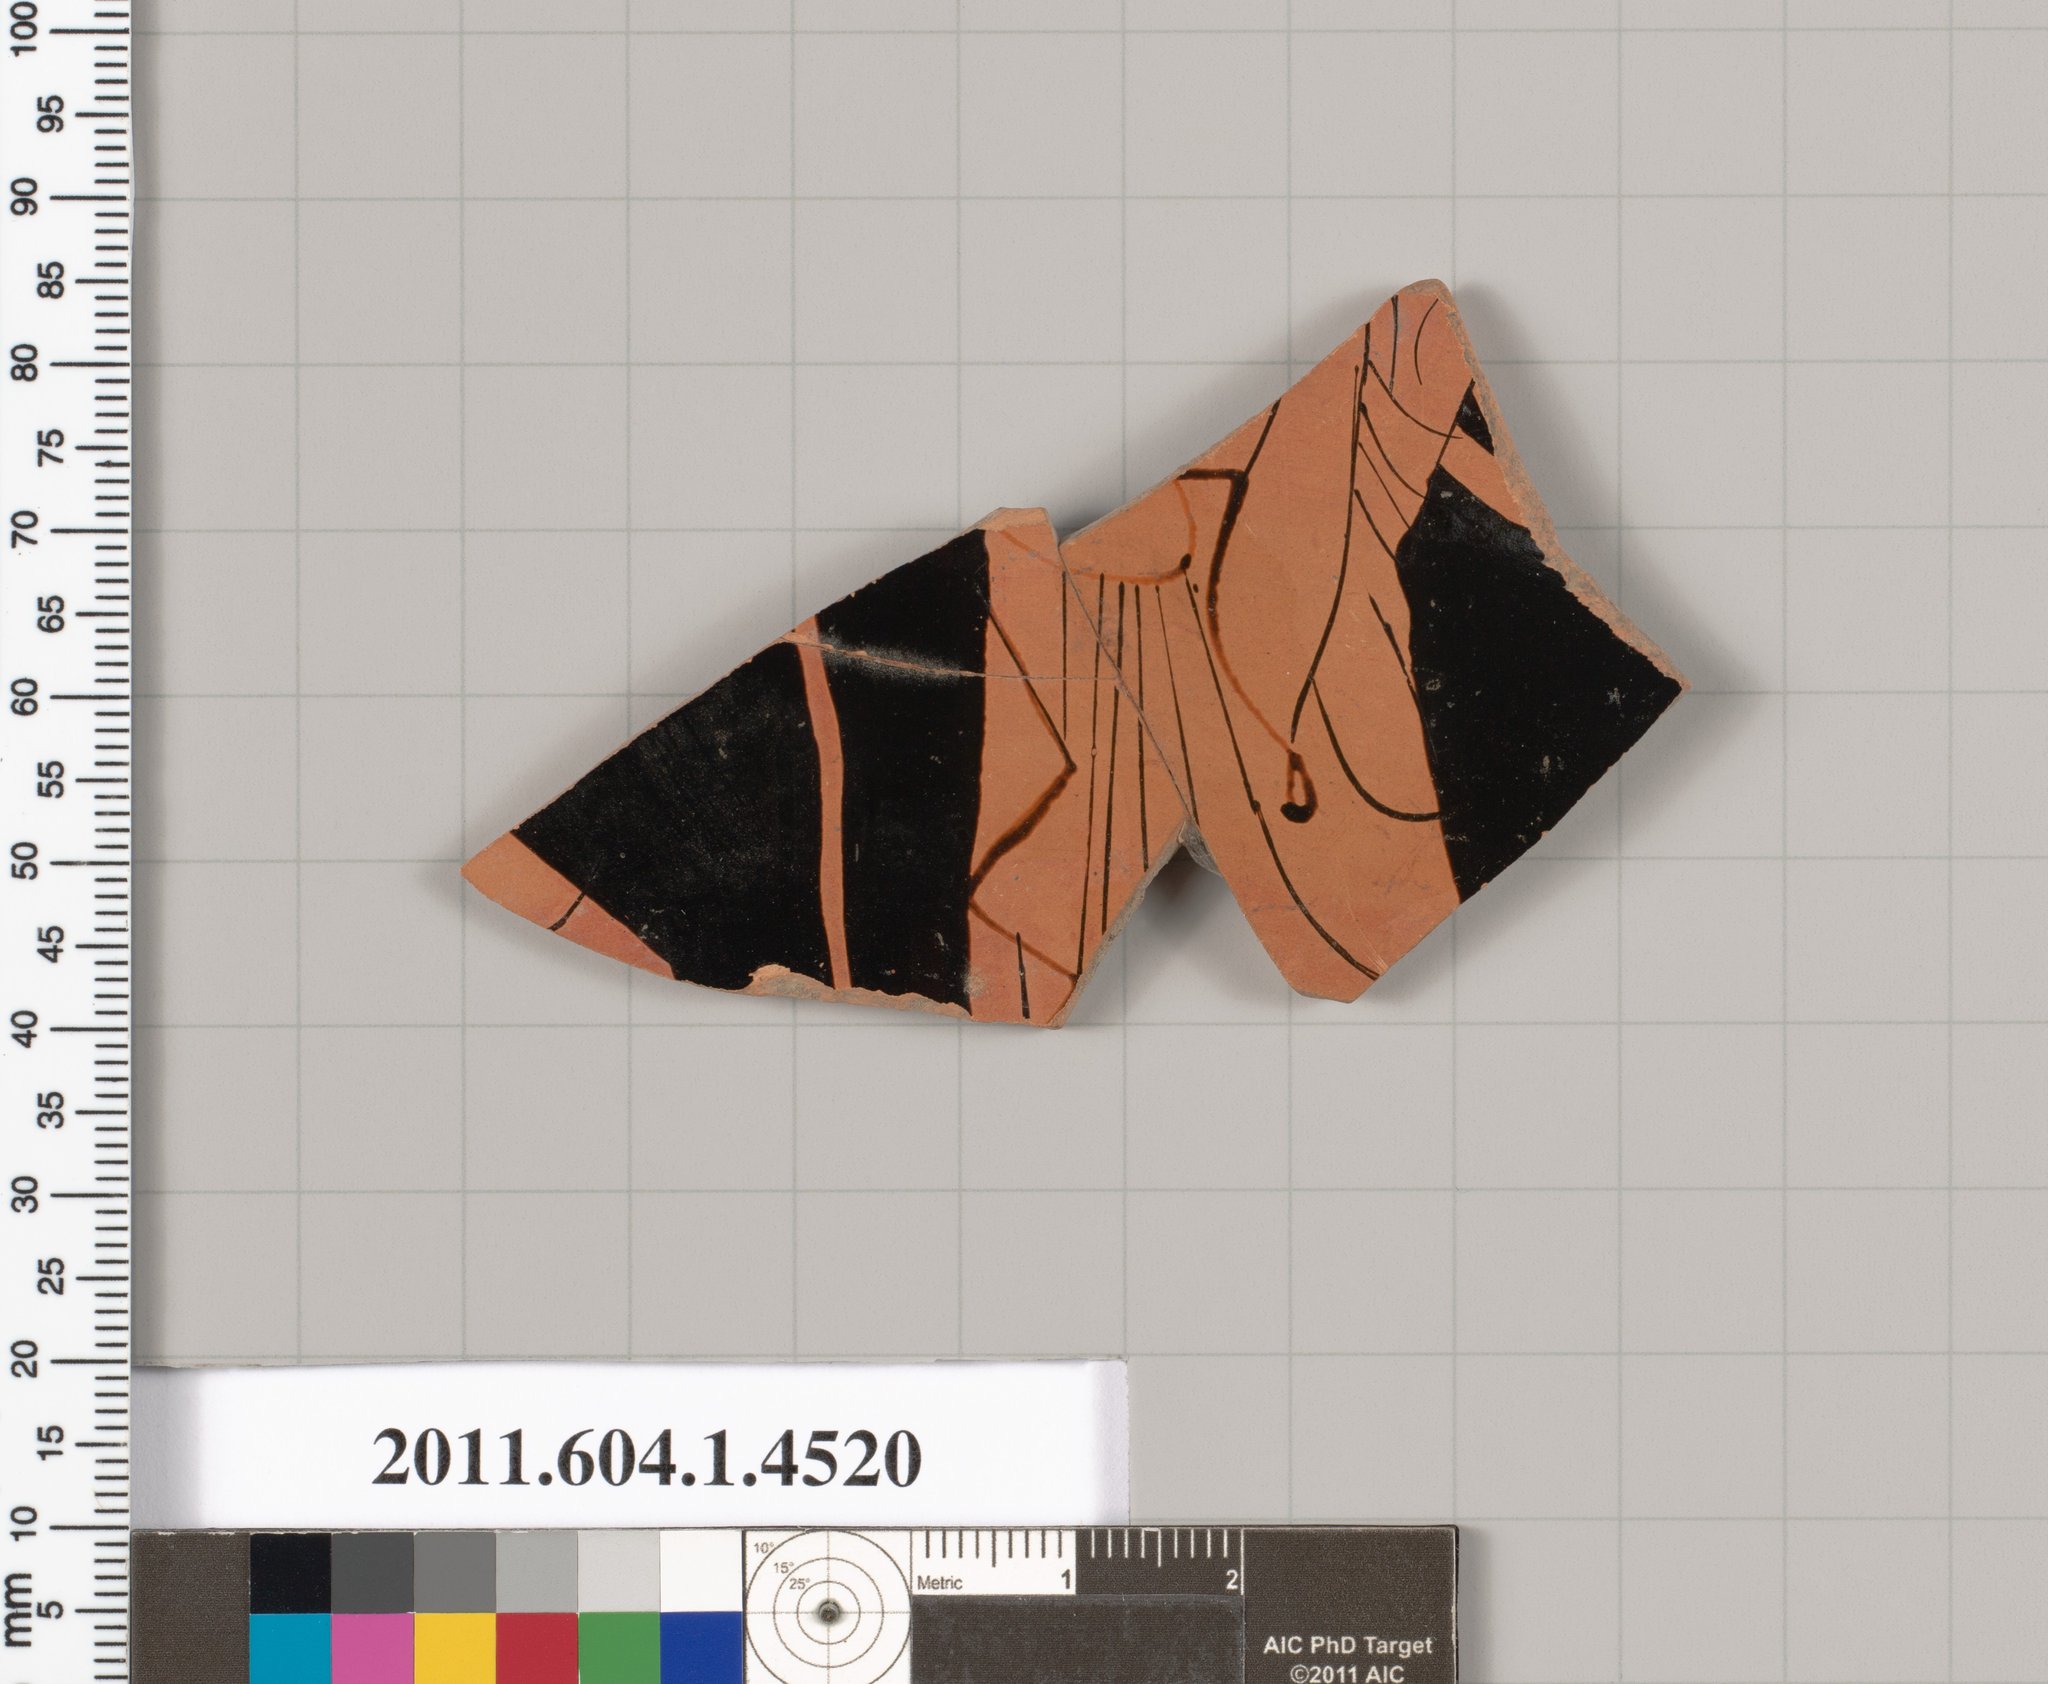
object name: kylix fragment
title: Terracotta fragment of a kylix (drinking cup)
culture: greek, attic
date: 467-435 BCE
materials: terracotta